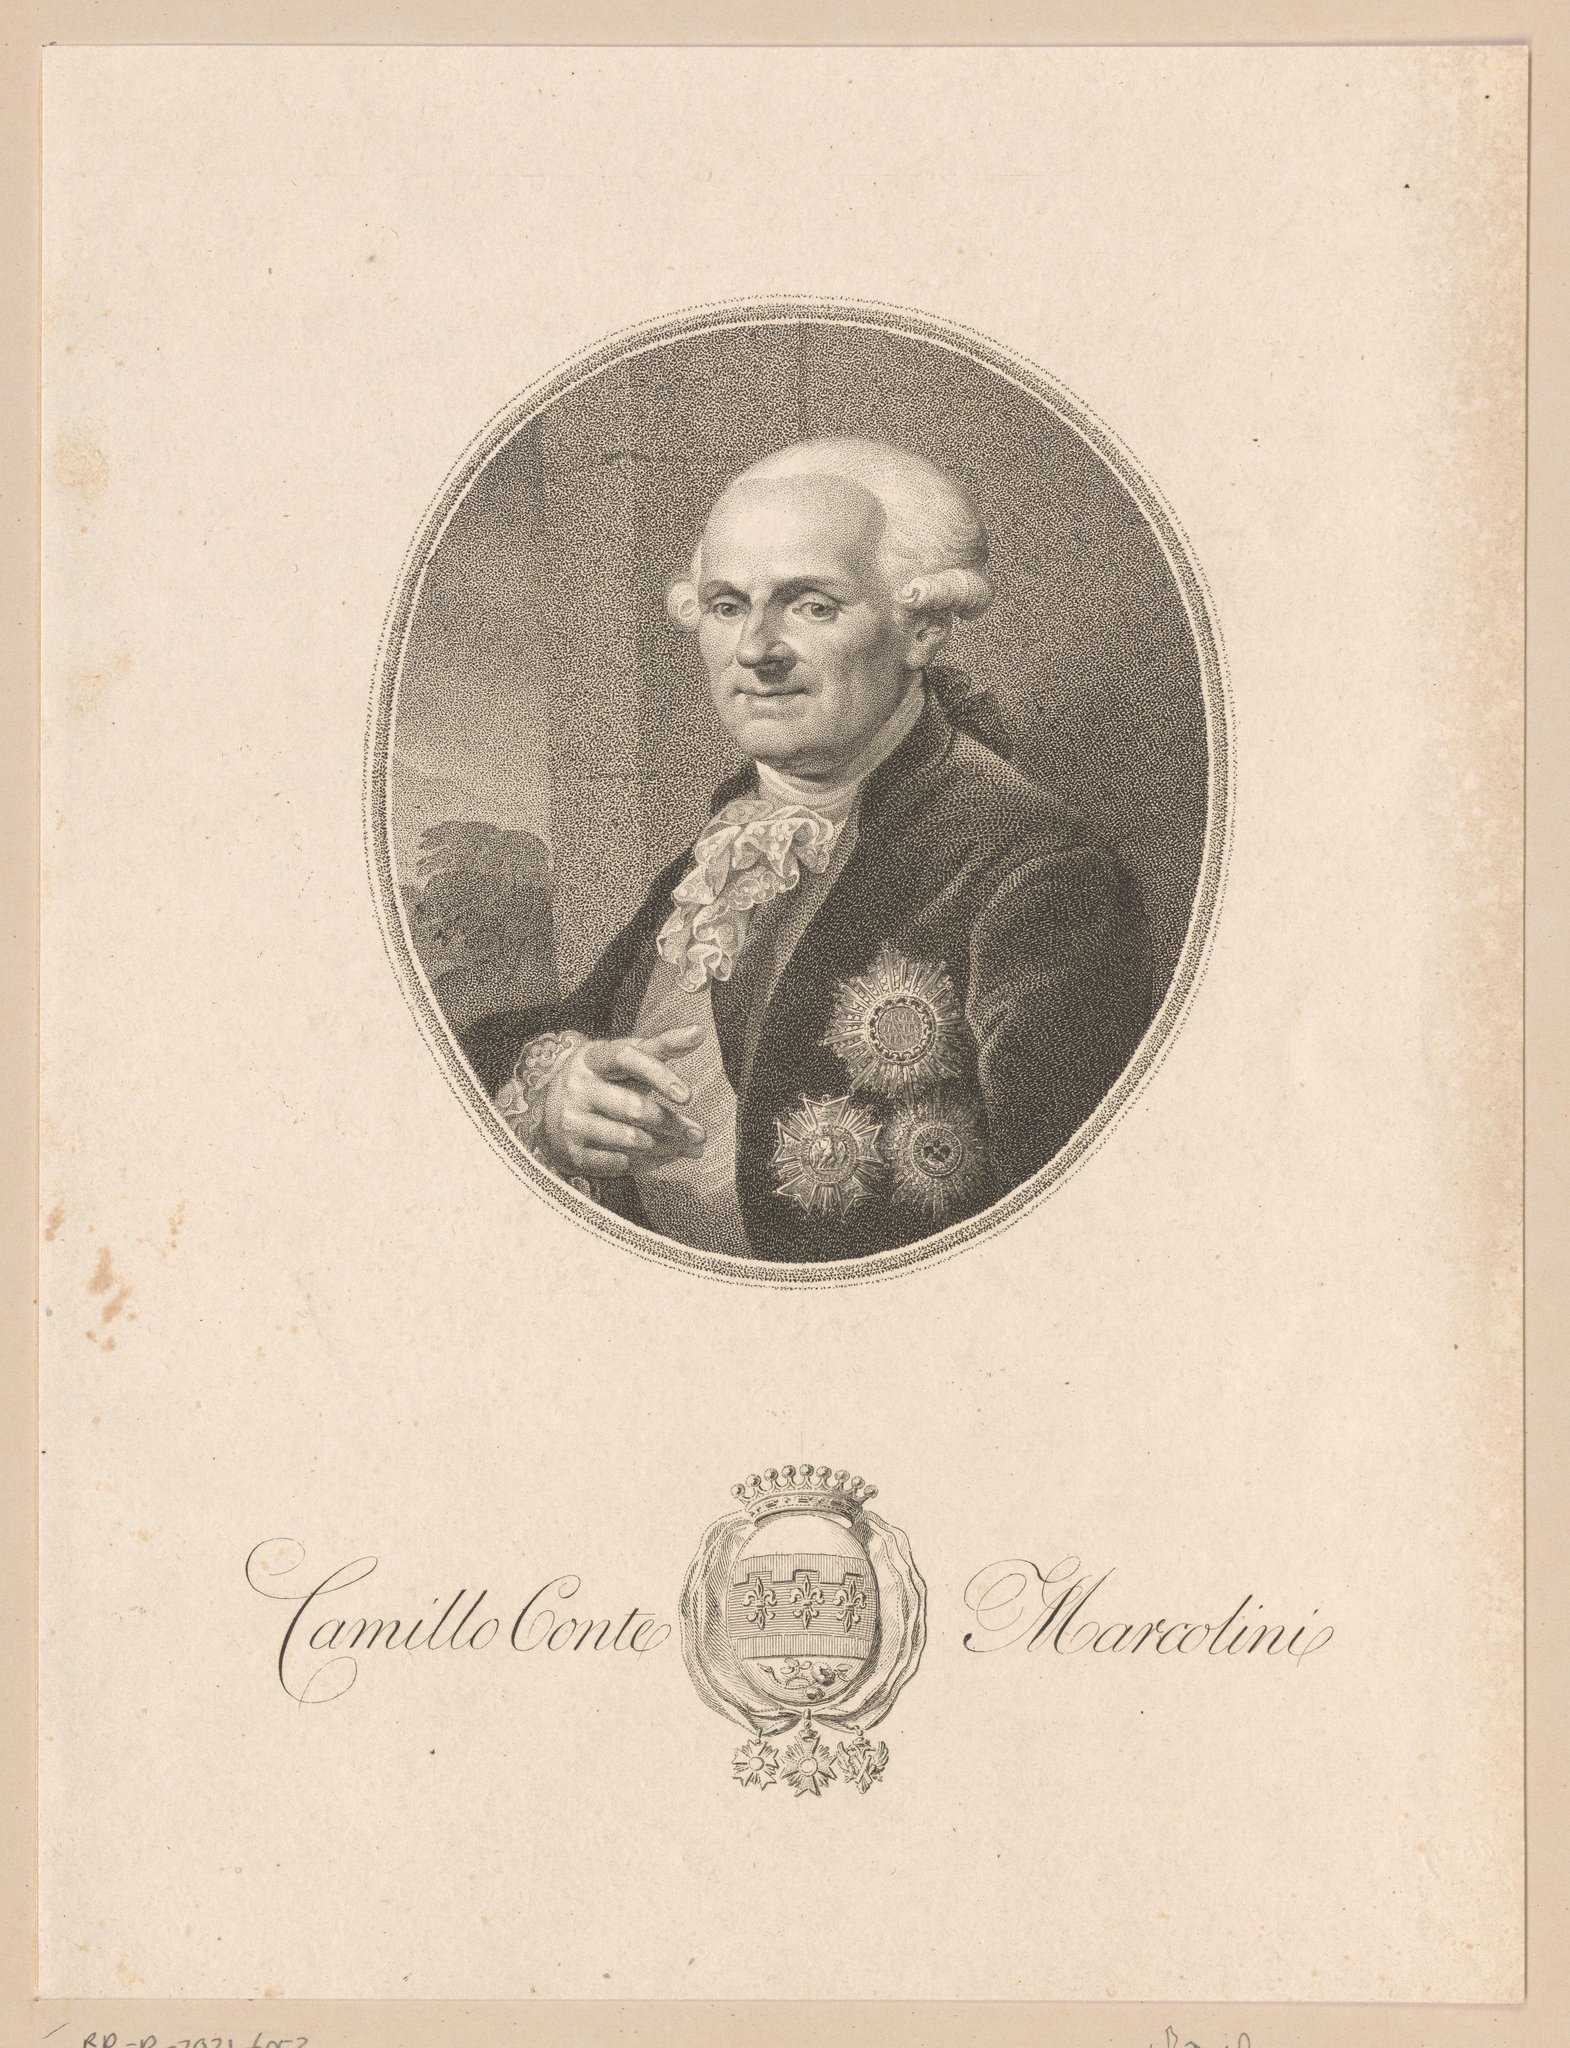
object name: print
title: Portret van Camillo Marcolini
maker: Anonymous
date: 1785-1814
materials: paper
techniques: engraving, etching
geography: italy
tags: prague, earl, camillo graaf marcolini, knighthood order, historical persons, wig, armorial bearing, heraldry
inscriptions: collector's mark: Lugt 1388